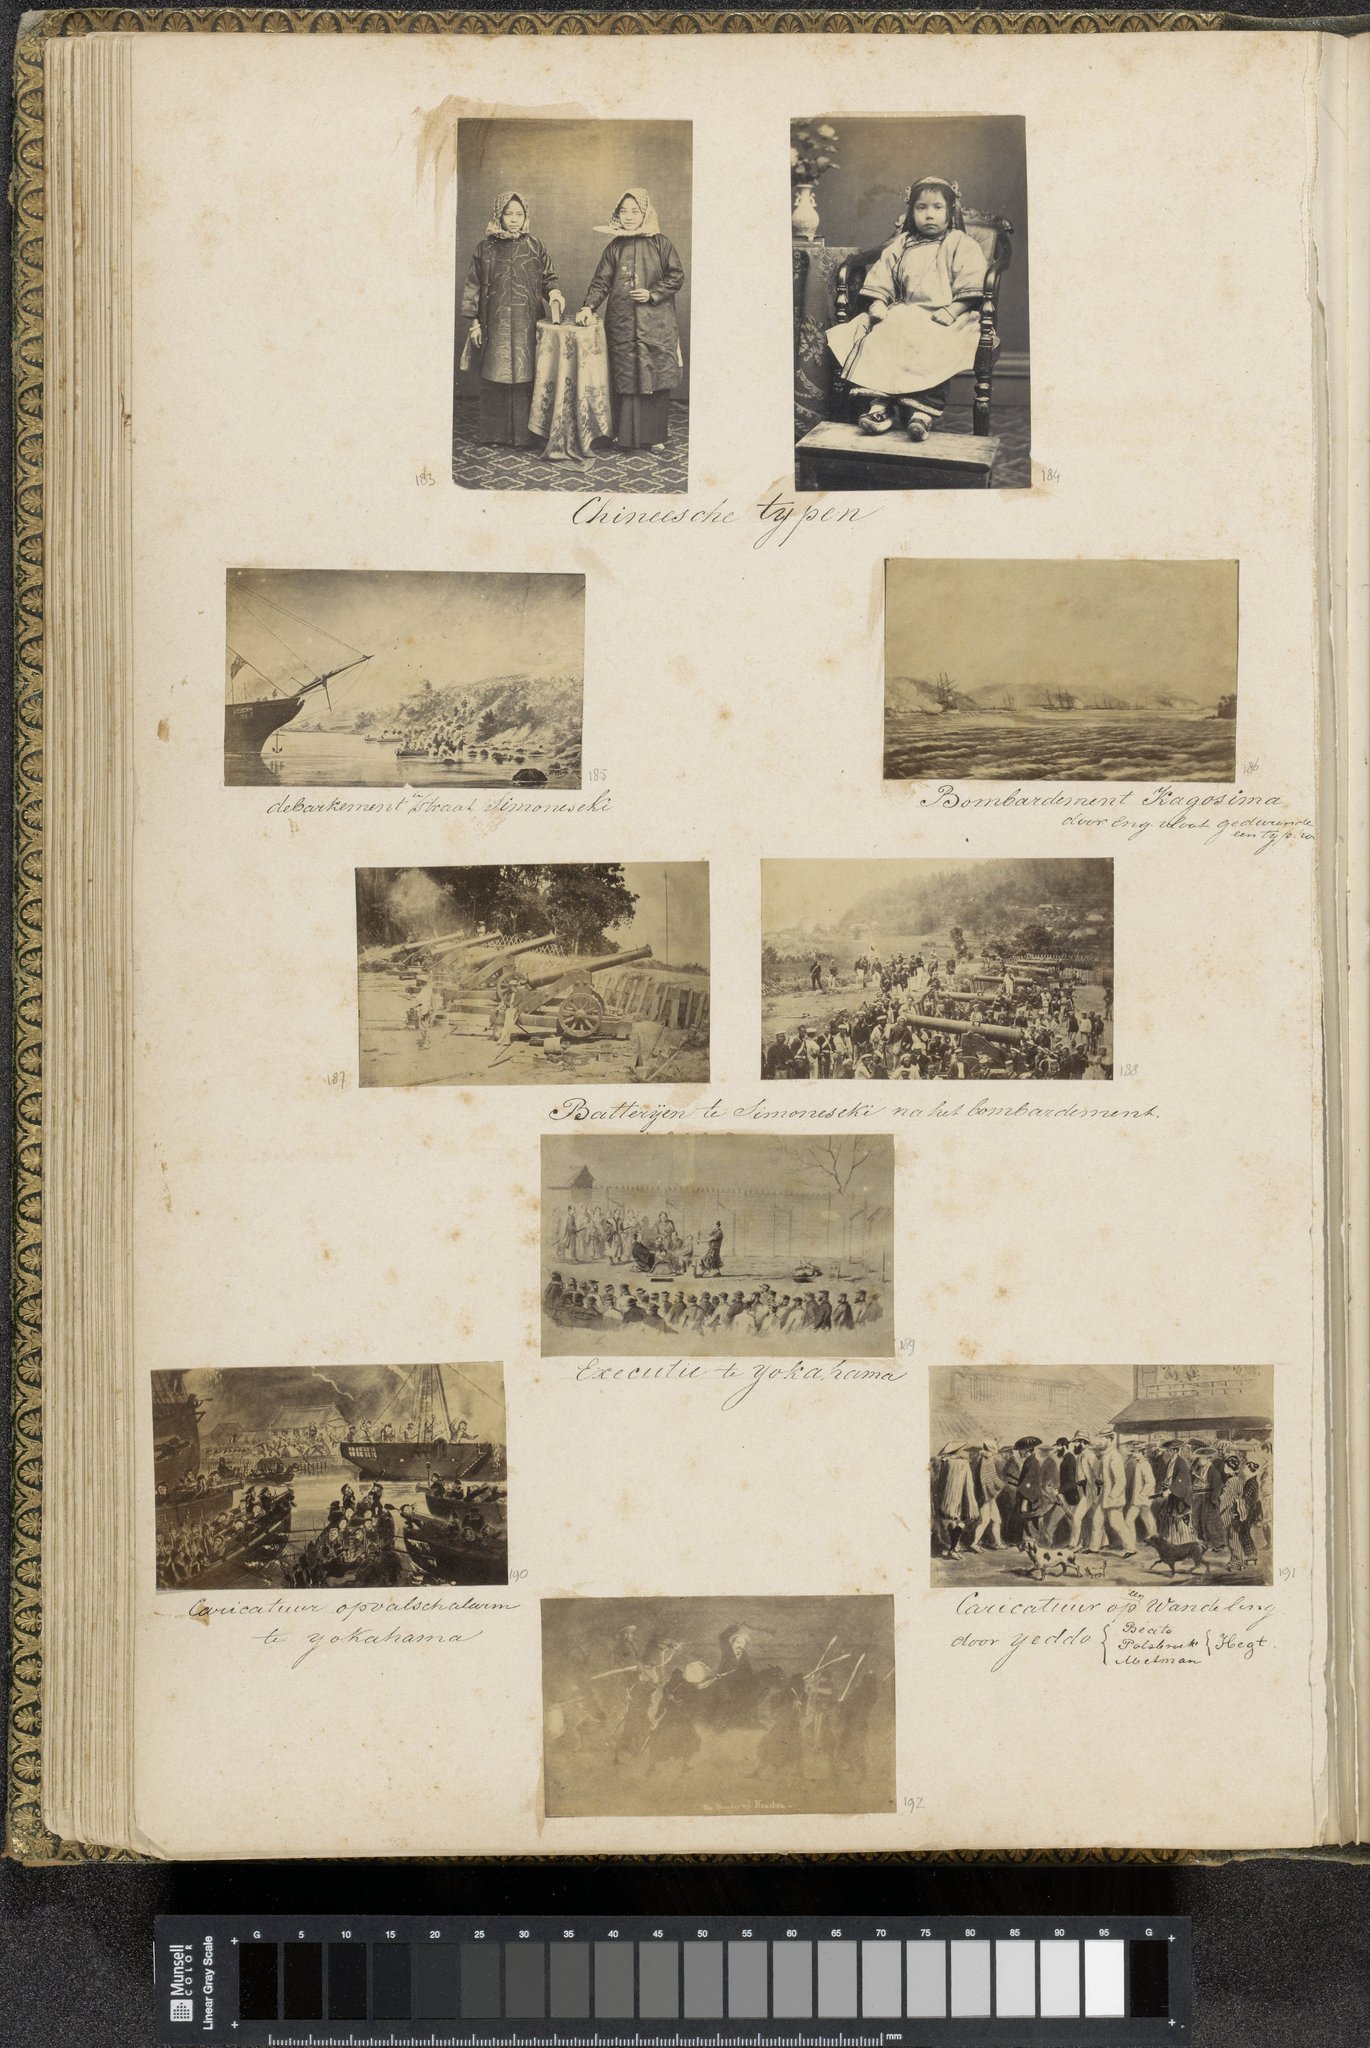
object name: reproduction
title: Fotoreproductie van (vermoedelijk) een tekening voorstellend het bombardement van Kagosima door een Engelse vloot tijdens een tyfoon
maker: Anonymous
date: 1863-1880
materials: paper, photographic support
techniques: albumen print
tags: battle (+ naval force)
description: Onderdeel van Fotoalbum van Robert Daniel Crommelin (1841-1907).